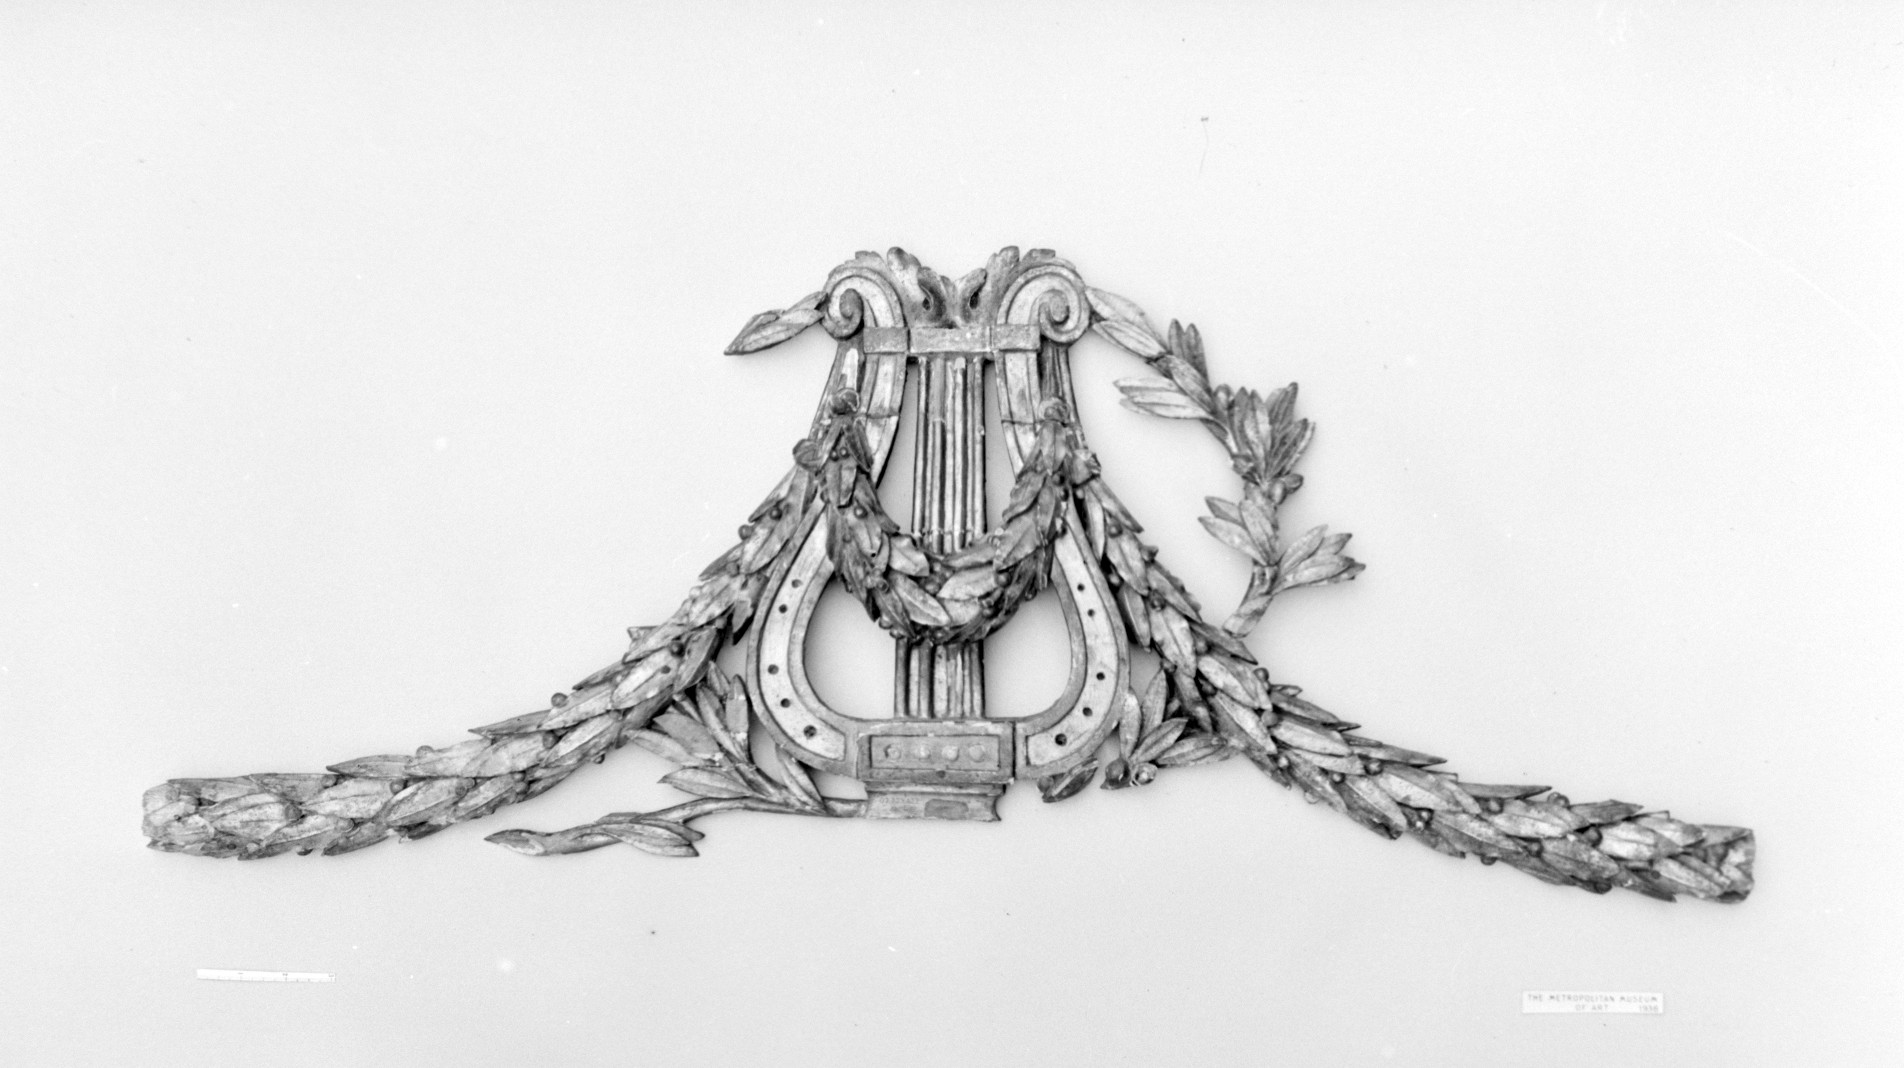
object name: ornament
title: Lyre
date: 1701-1800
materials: wood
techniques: carving, gilding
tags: musical instruments